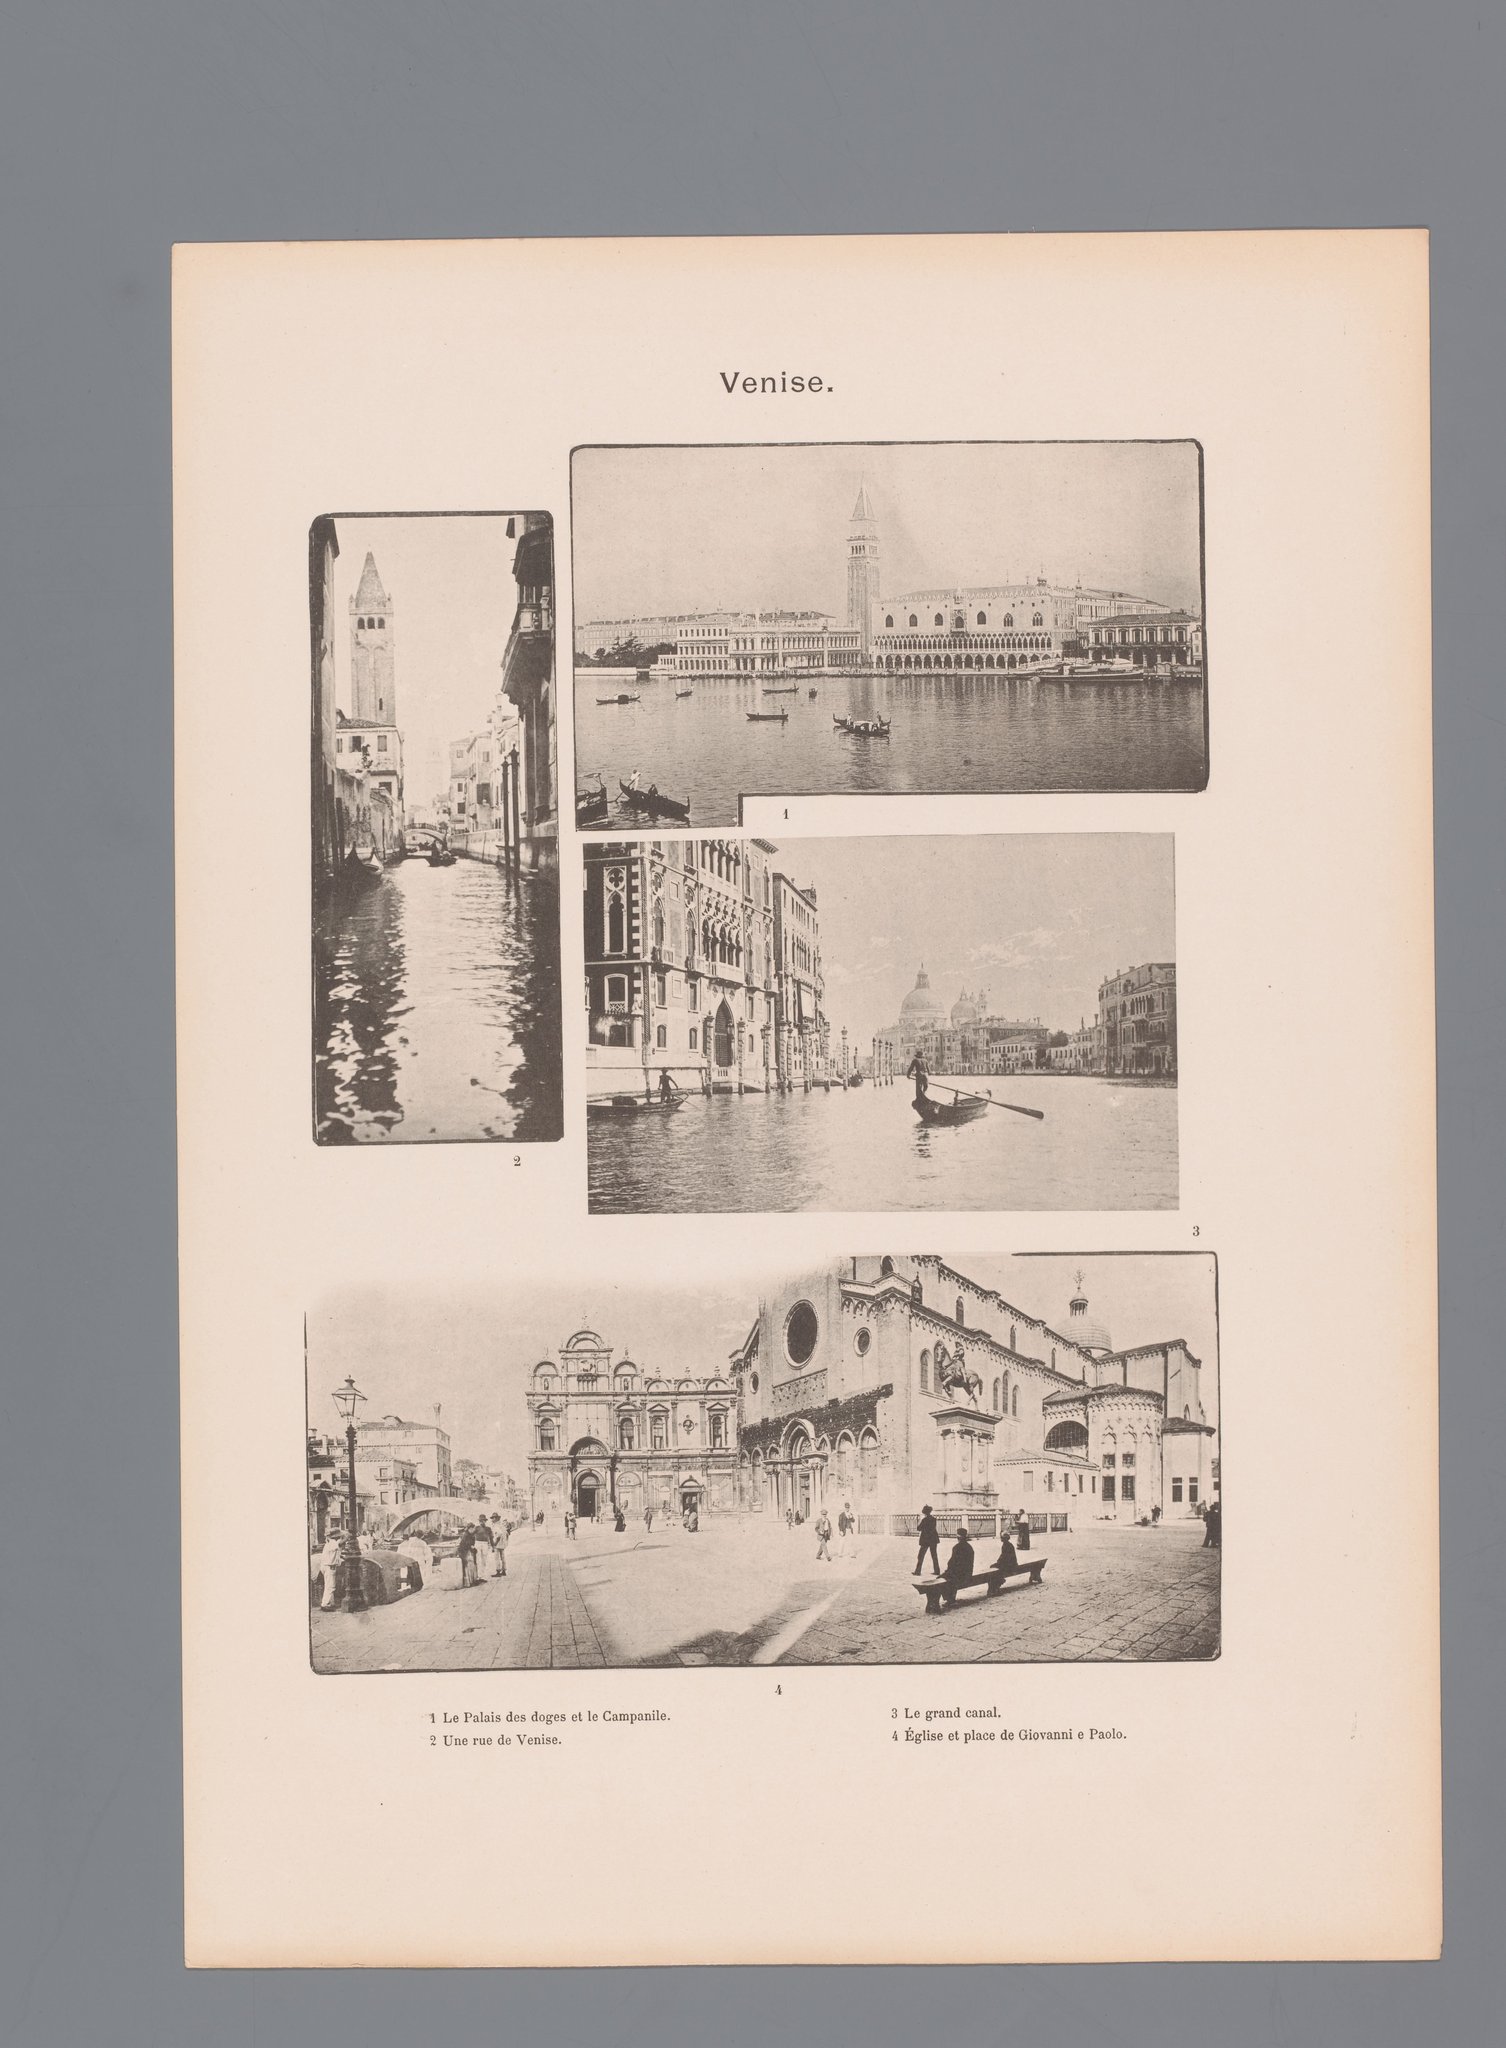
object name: photomechanical print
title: Venise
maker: Anonymous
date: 1893-1898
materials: paper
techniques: photograph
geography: venice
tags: canals, waters (in city), prospect of city, town panorama, silhouette of city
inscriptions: inscription: ‘1 Le Palais des doges et le Campanile./ 2 Une rue de Venise./ 3 Le grand canal./ 4 Église et place de Giovanni e Paolo.’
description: Deze prenten maken deel uit van een omslag met 103 prenten op 16 bladen en een titelblad.